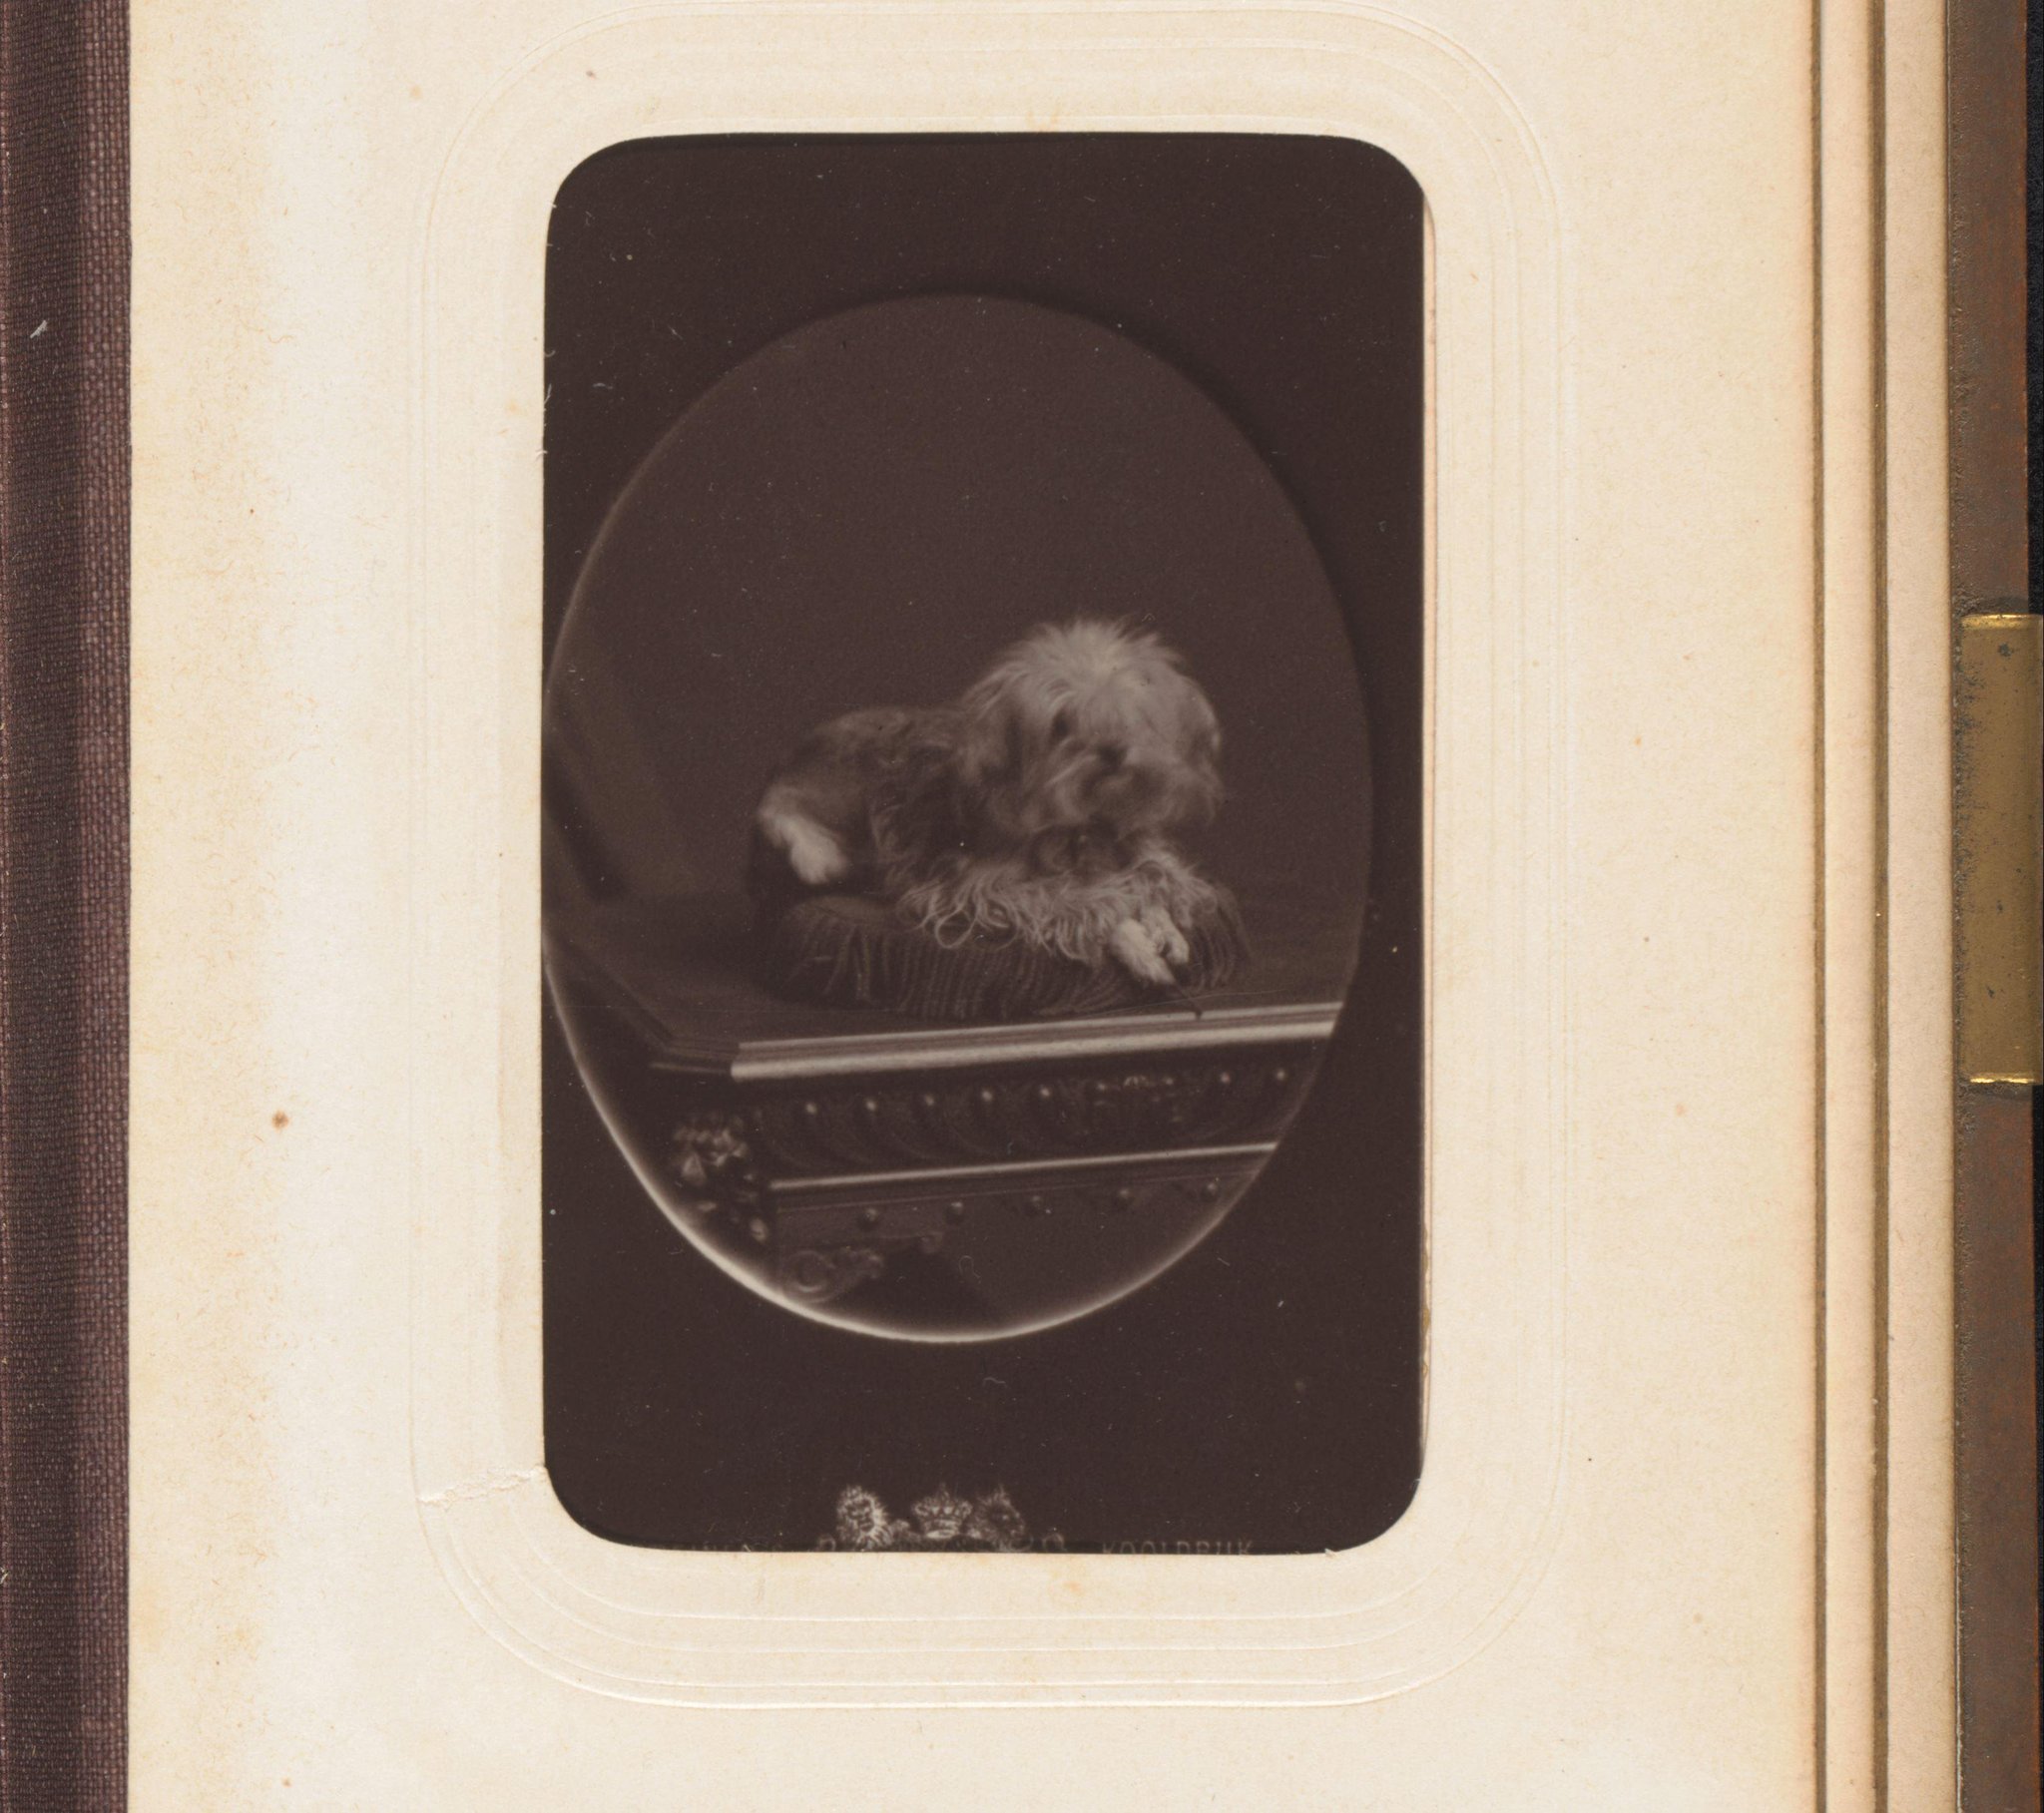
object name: photograph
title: Portret van een hond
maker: albert greiner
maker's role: fotograaf, fotostudio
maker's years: 1833-1890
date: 1879-1890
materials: cardboard, paper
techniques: carbon print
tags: dog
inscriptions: inscription: ‘opm. verso Nieuwendijk L89 Amsterdam’